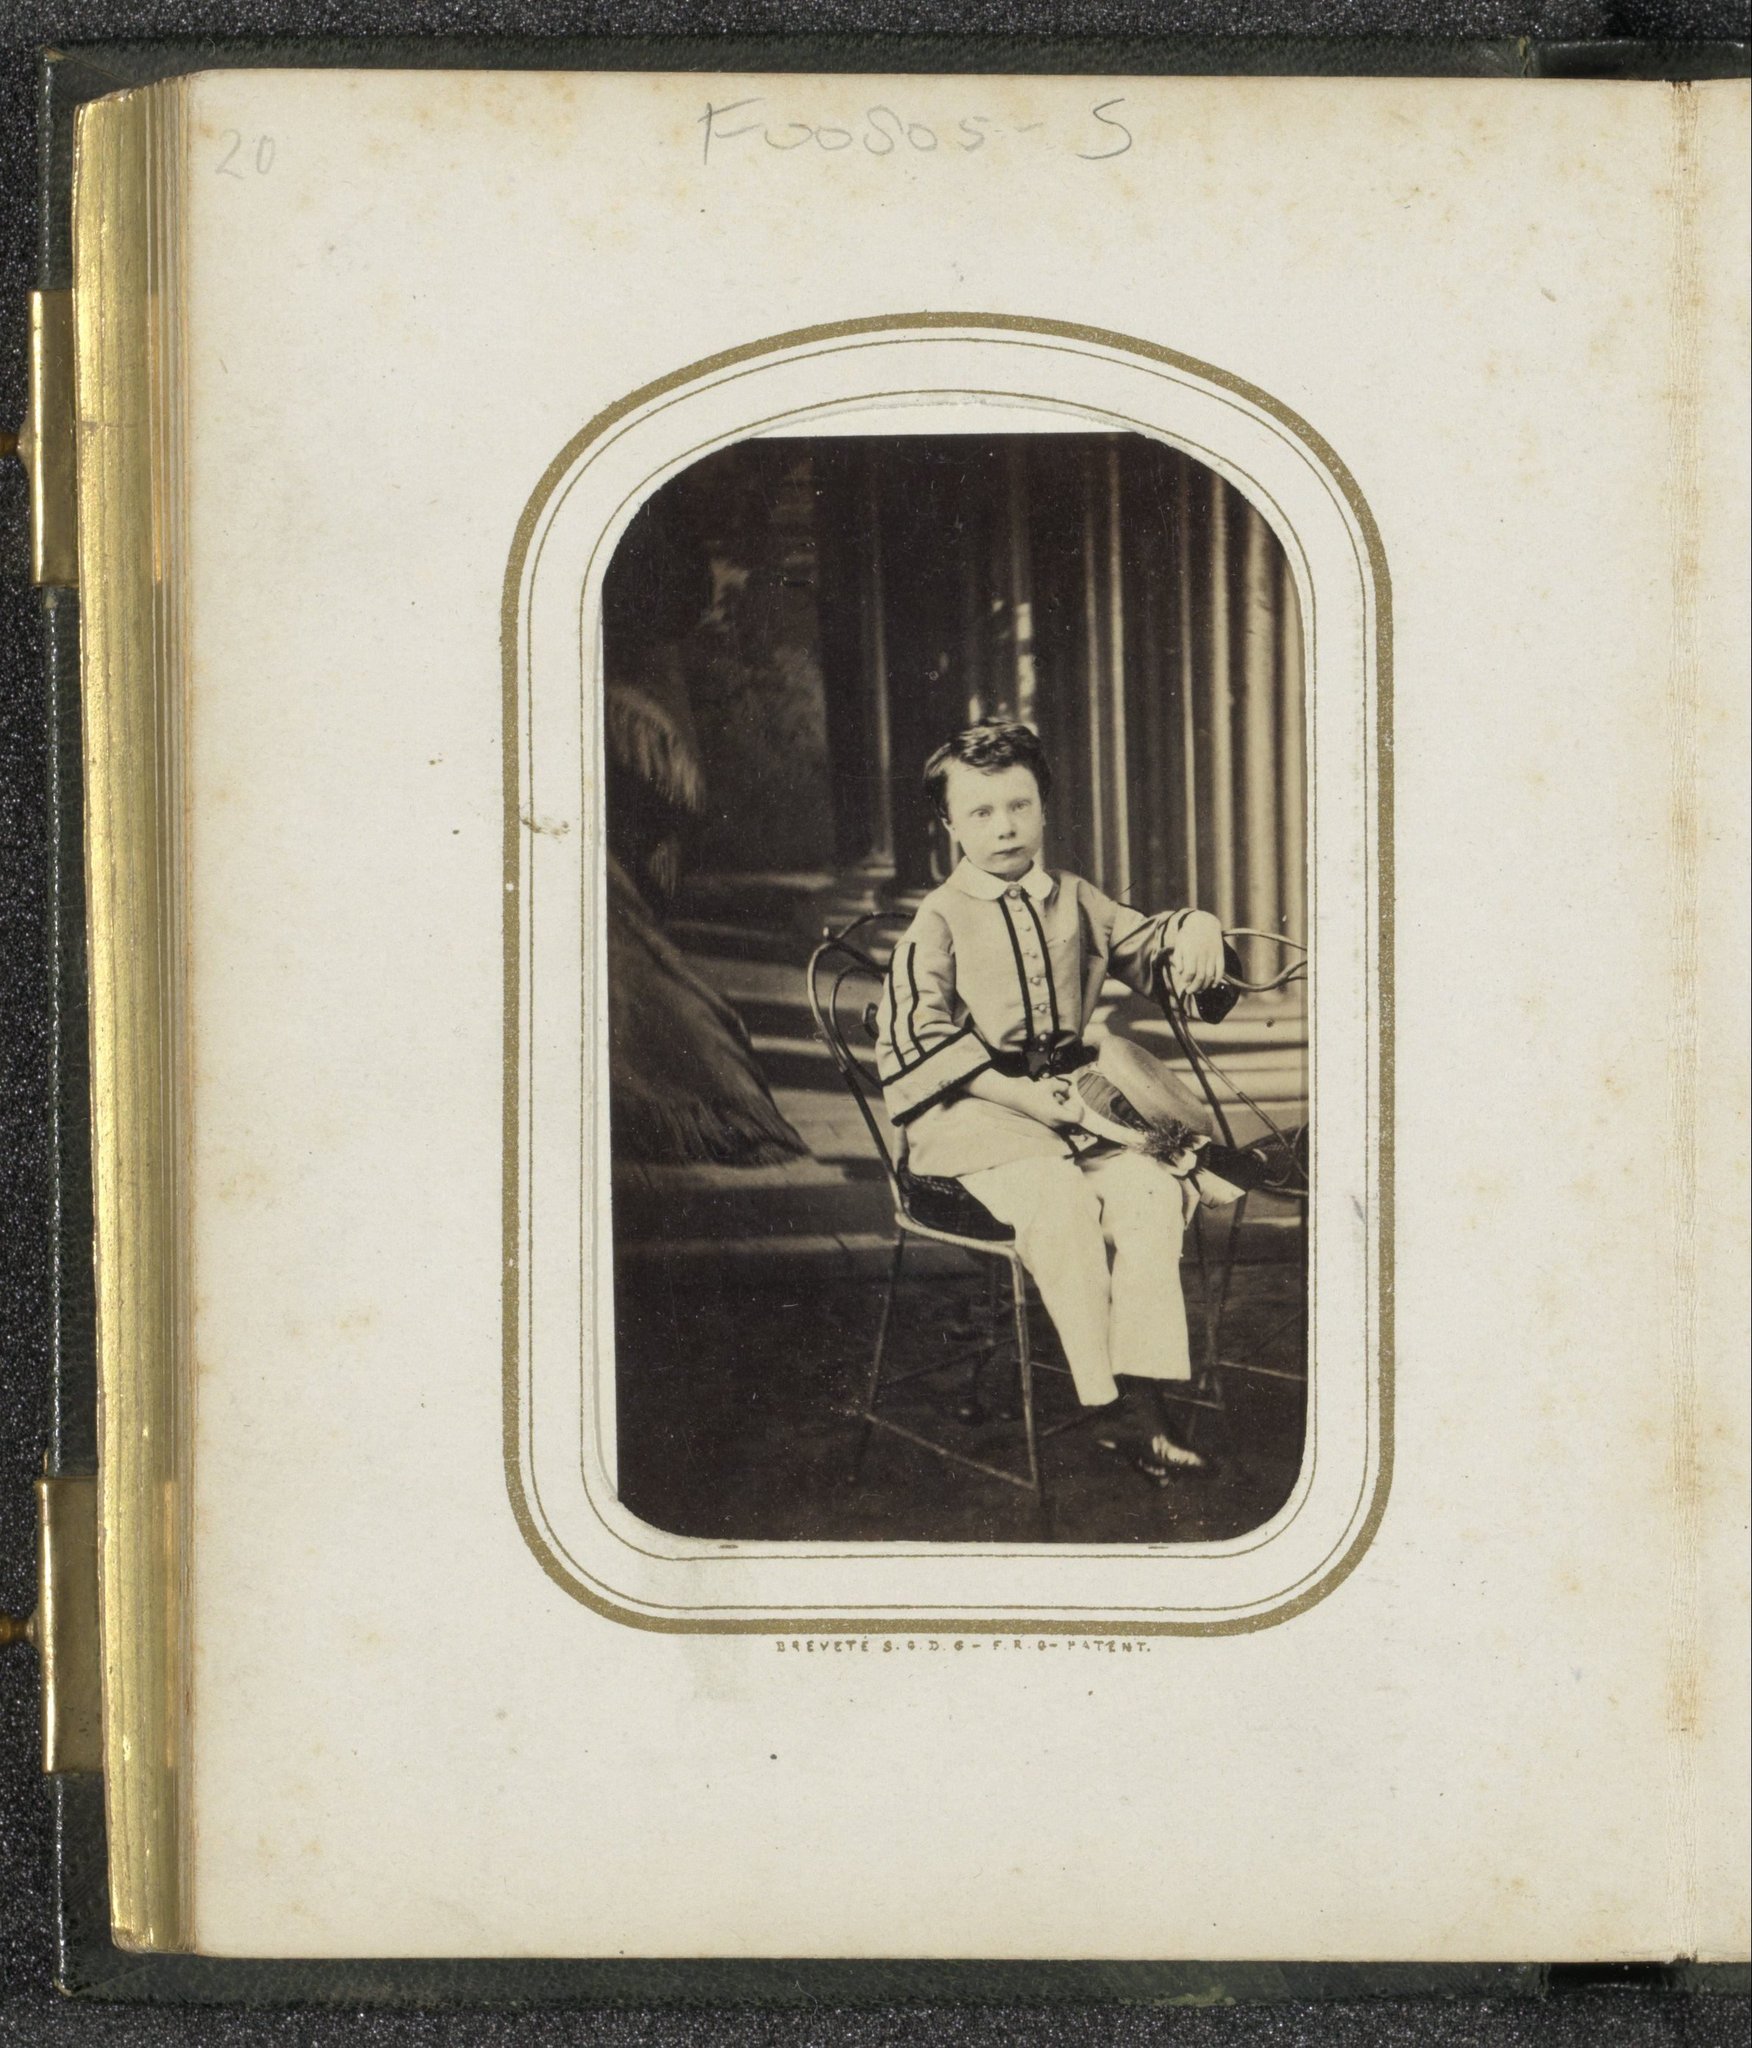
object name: photograph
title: Portret van prins Alexander, zoon van koning Willem III, als kind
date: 1860-1870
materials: cardboard, paper, photographic support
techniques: albumen print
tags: the hague, studio requisites ~ photographer, trousers, breeches, prince, child, historical persons, clothing for the upper part of the body, chair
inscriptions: inscription: ‘Pce. des Pays Bas’, address: ‘Rue des Fripiers 32 Bruxelles’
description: Onderdeel van Fotoalbum met 29 foto's van Nederlandse vorsten.